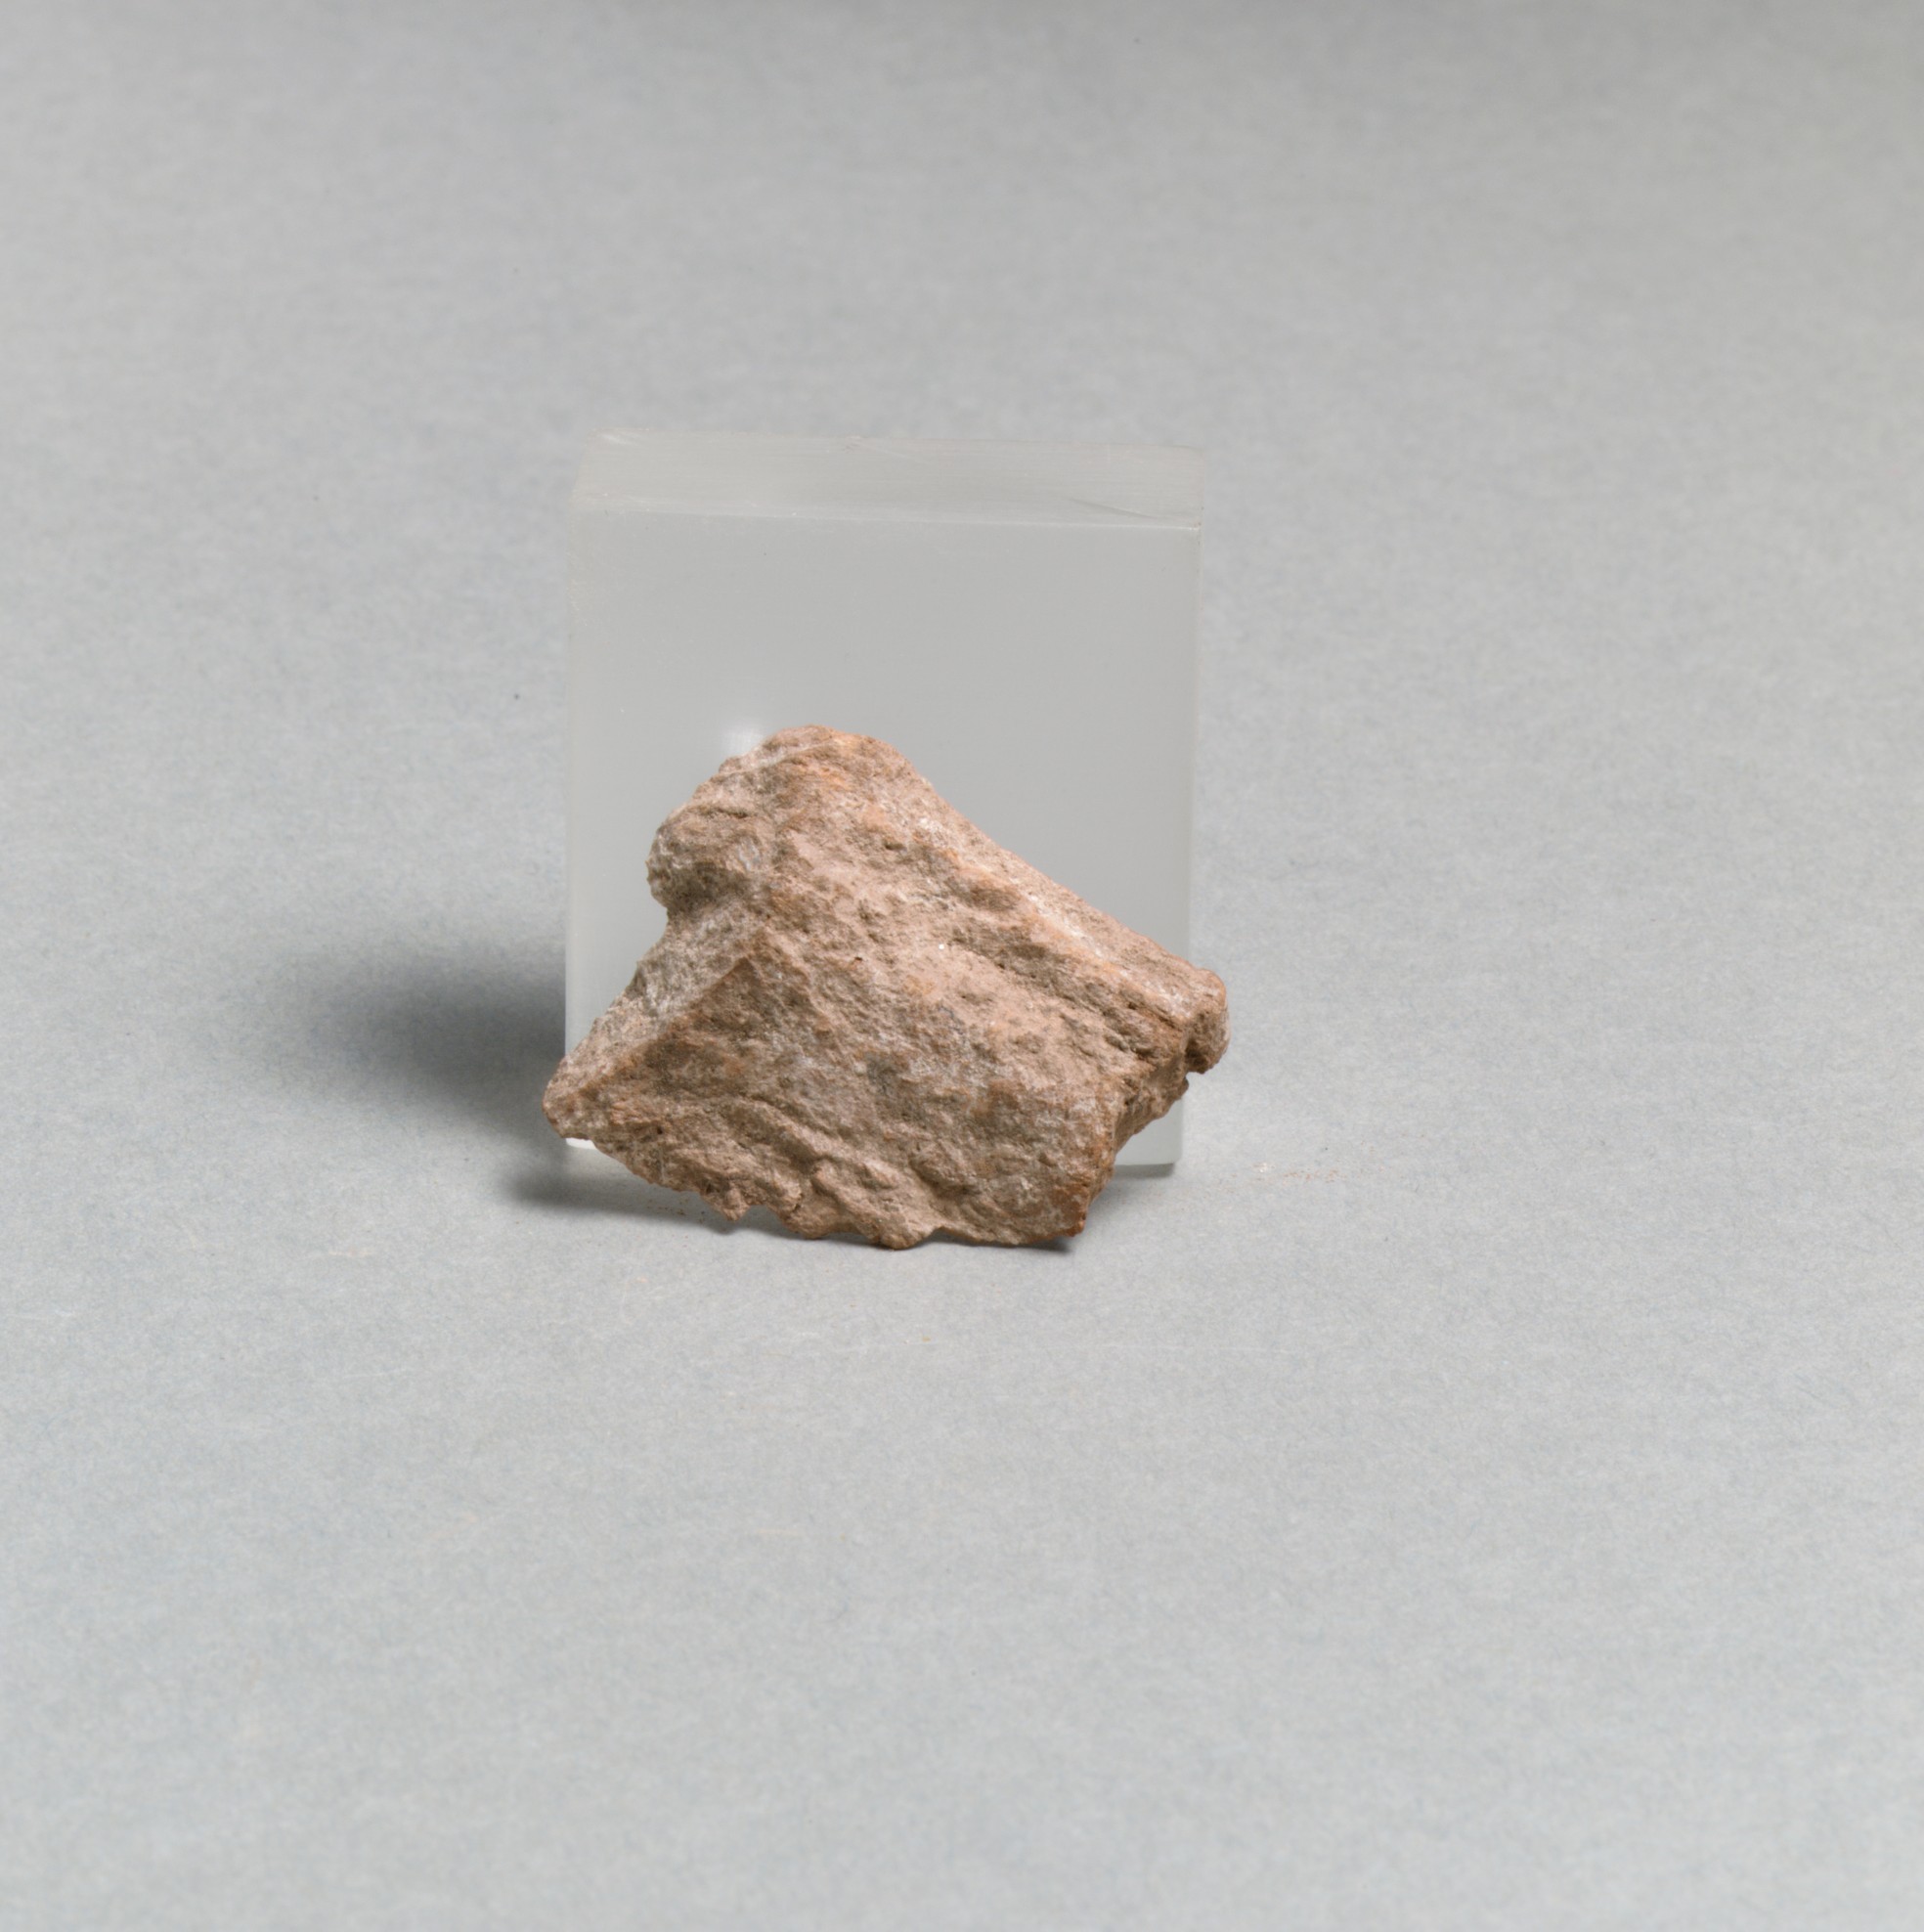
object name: vase fragment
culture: greek or lydian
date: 1050-700 BCE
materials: terracotta